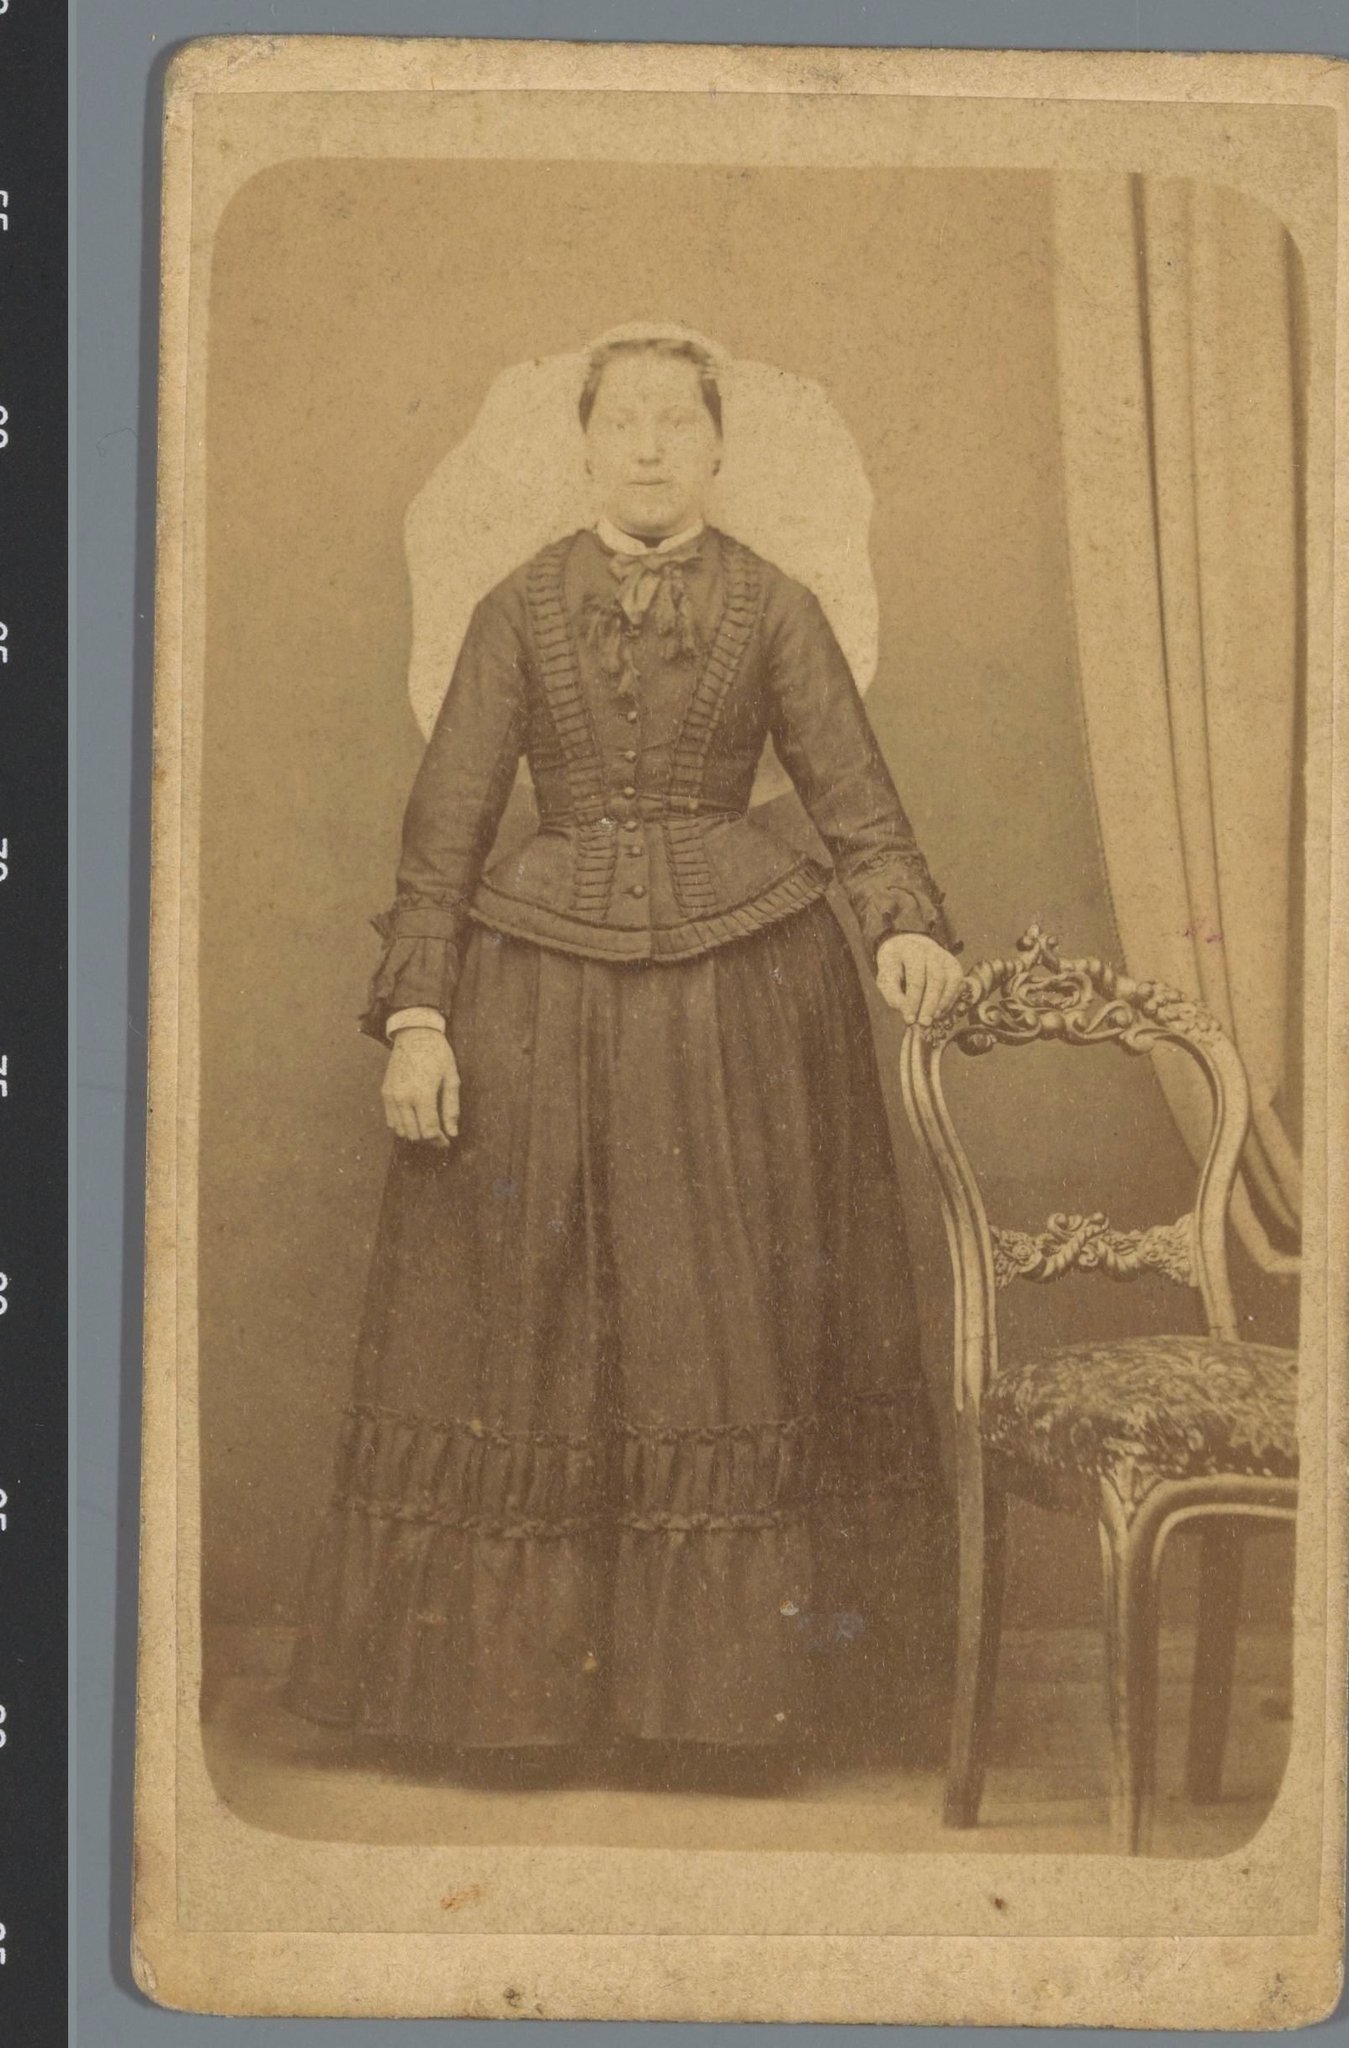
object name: carte de visite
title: Portret van een onbekende vrouw naast een stoel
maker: Anonymous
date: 1854-1885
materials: cardboard, paper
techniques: albumen print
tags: adult woman, anonymous historical person portrayed